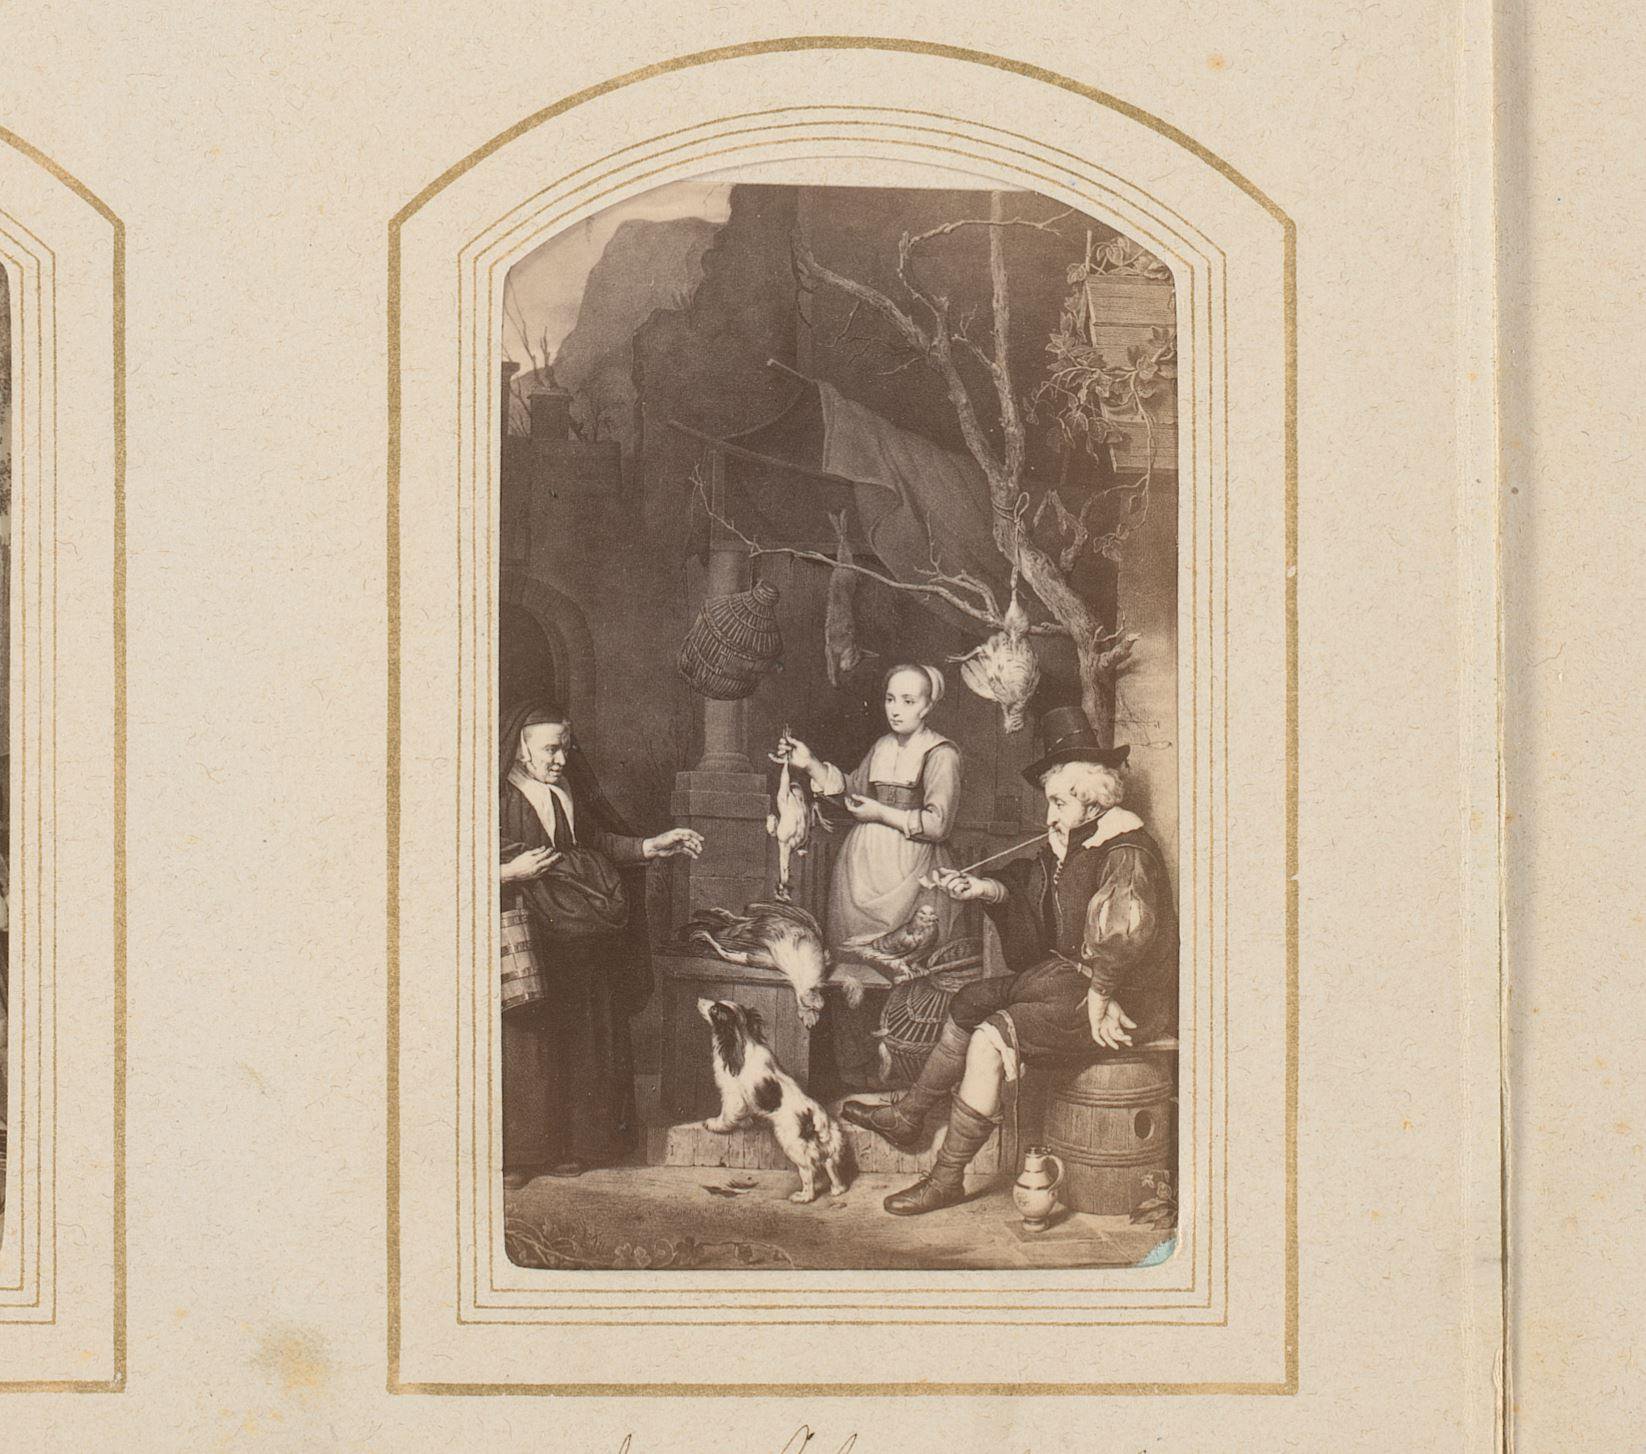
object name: reproduction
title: Fotoreproductie van Jonge vrouw die gevogelte verkoopt door Gabriel Metsu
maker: pg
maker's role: fotograaf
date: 1870-1890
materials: cardboard, photographic support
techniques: albumen print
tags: adult woman, adult man, pipe ~ tobacco, fowl (cock, hen, chicken, etc.), persons engaged in trade and commerce, painting, drawing and the graphic arts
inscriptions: number: ‘964’, annotation: ‘Der Federviehhandler’